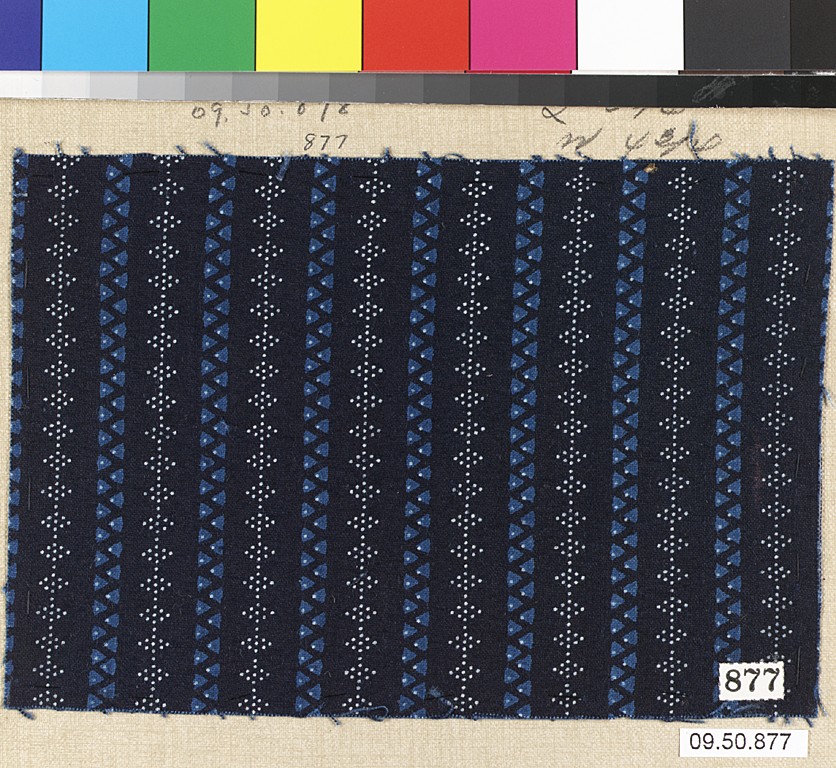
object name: piece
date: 1801-1900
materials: cotton